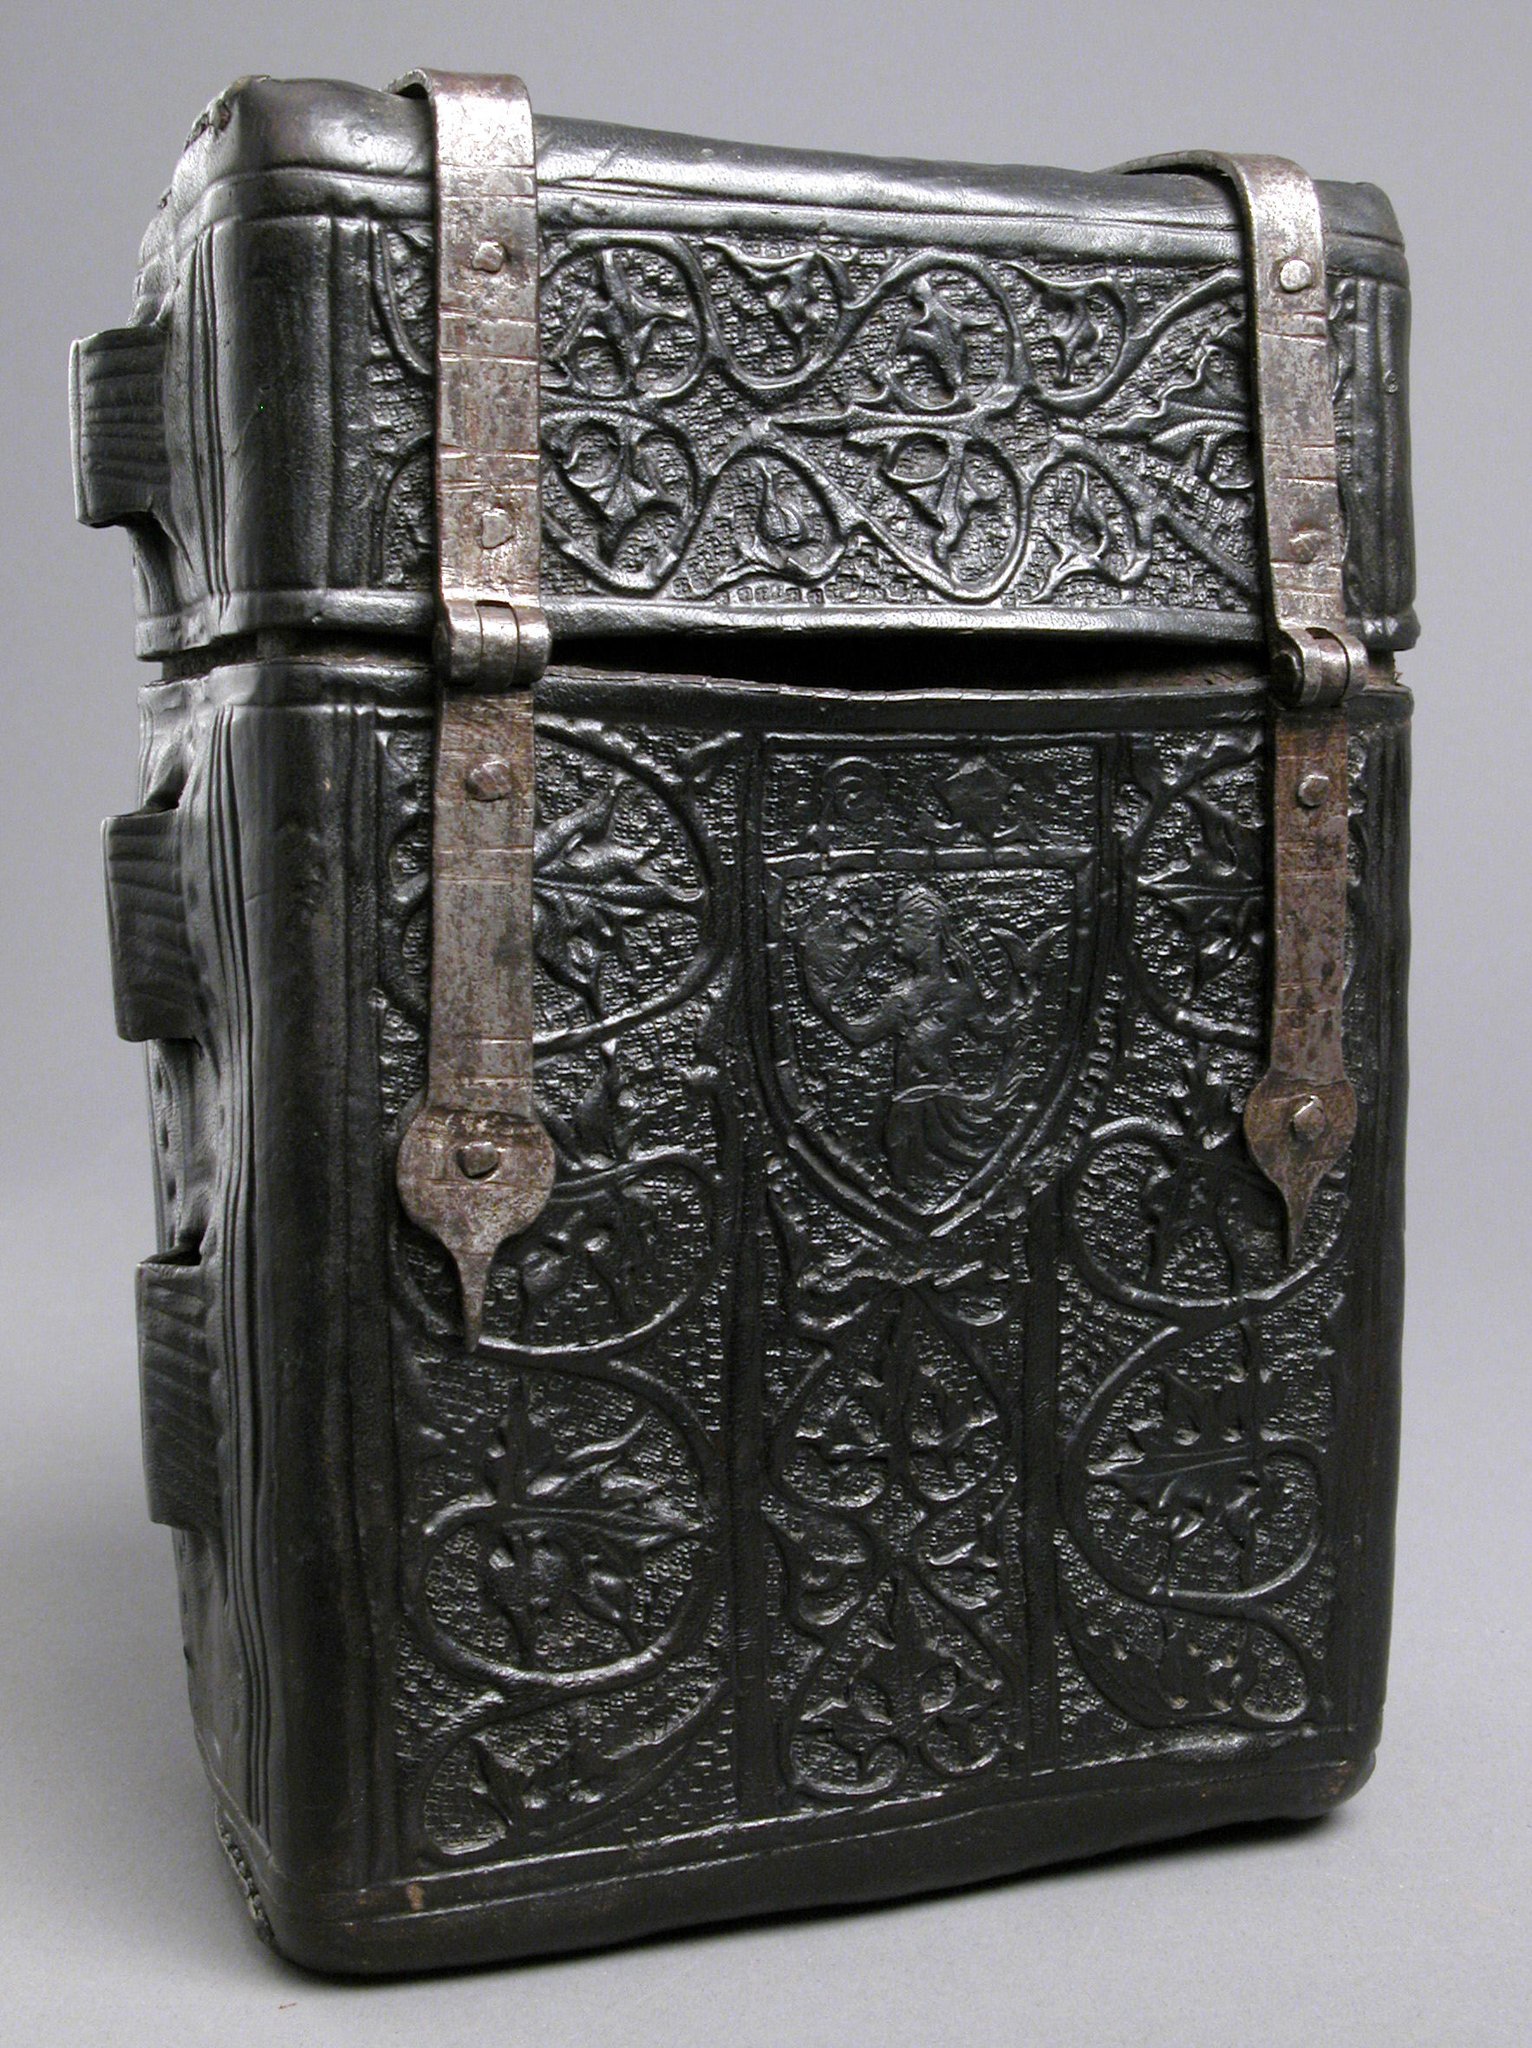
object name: book case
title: Case for a Book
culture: french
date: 1401-1500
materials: leather, metal